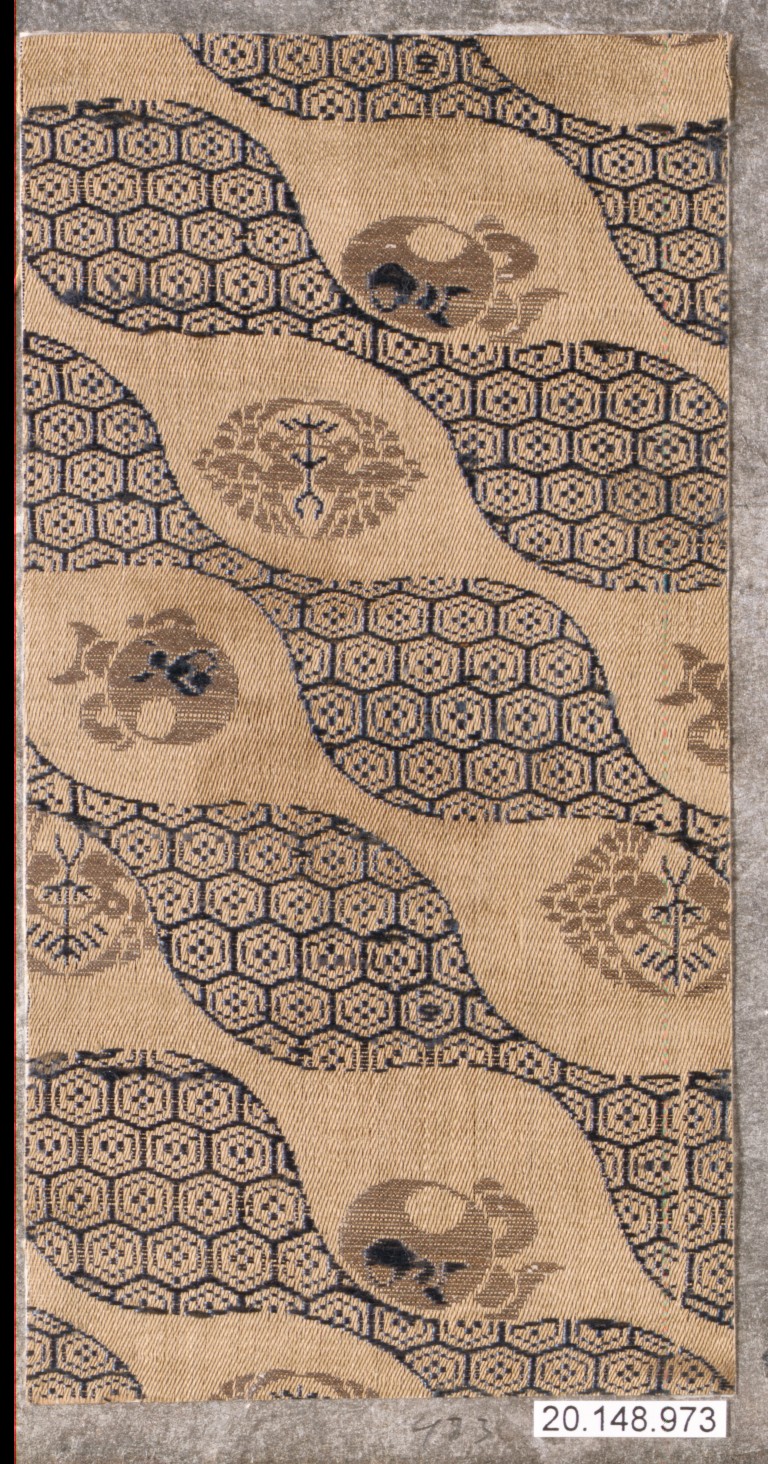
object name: piece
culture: japanese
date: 1701-1800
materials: silk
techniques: compound weave